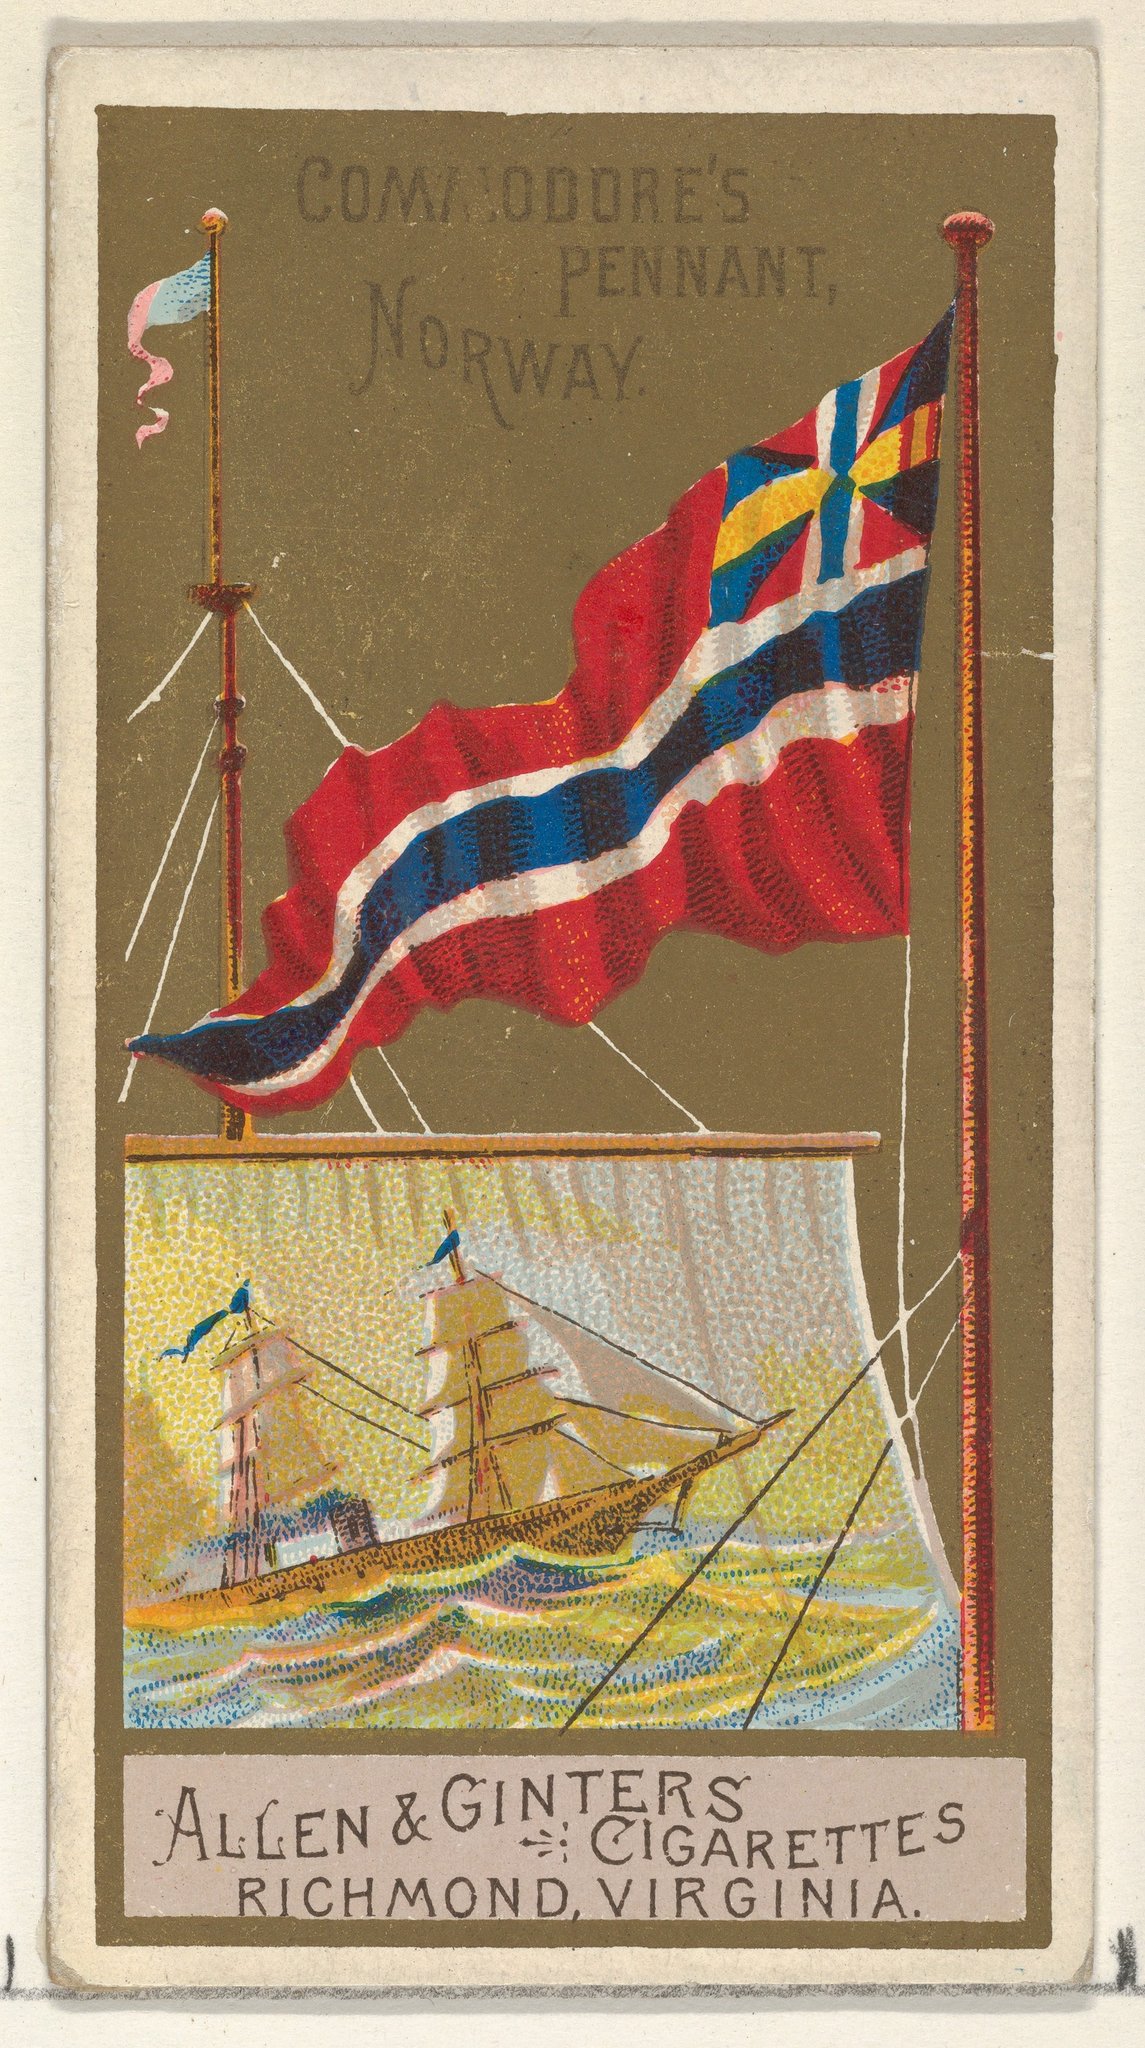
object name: print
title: Commodore's Pennant, Norway, from the Naval Flags series (N17) for Allen & Ginter Cigarettes Brands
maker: allen & ginter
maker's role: publisher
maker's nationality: american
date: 1888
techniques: color lithograph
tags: flags,ships